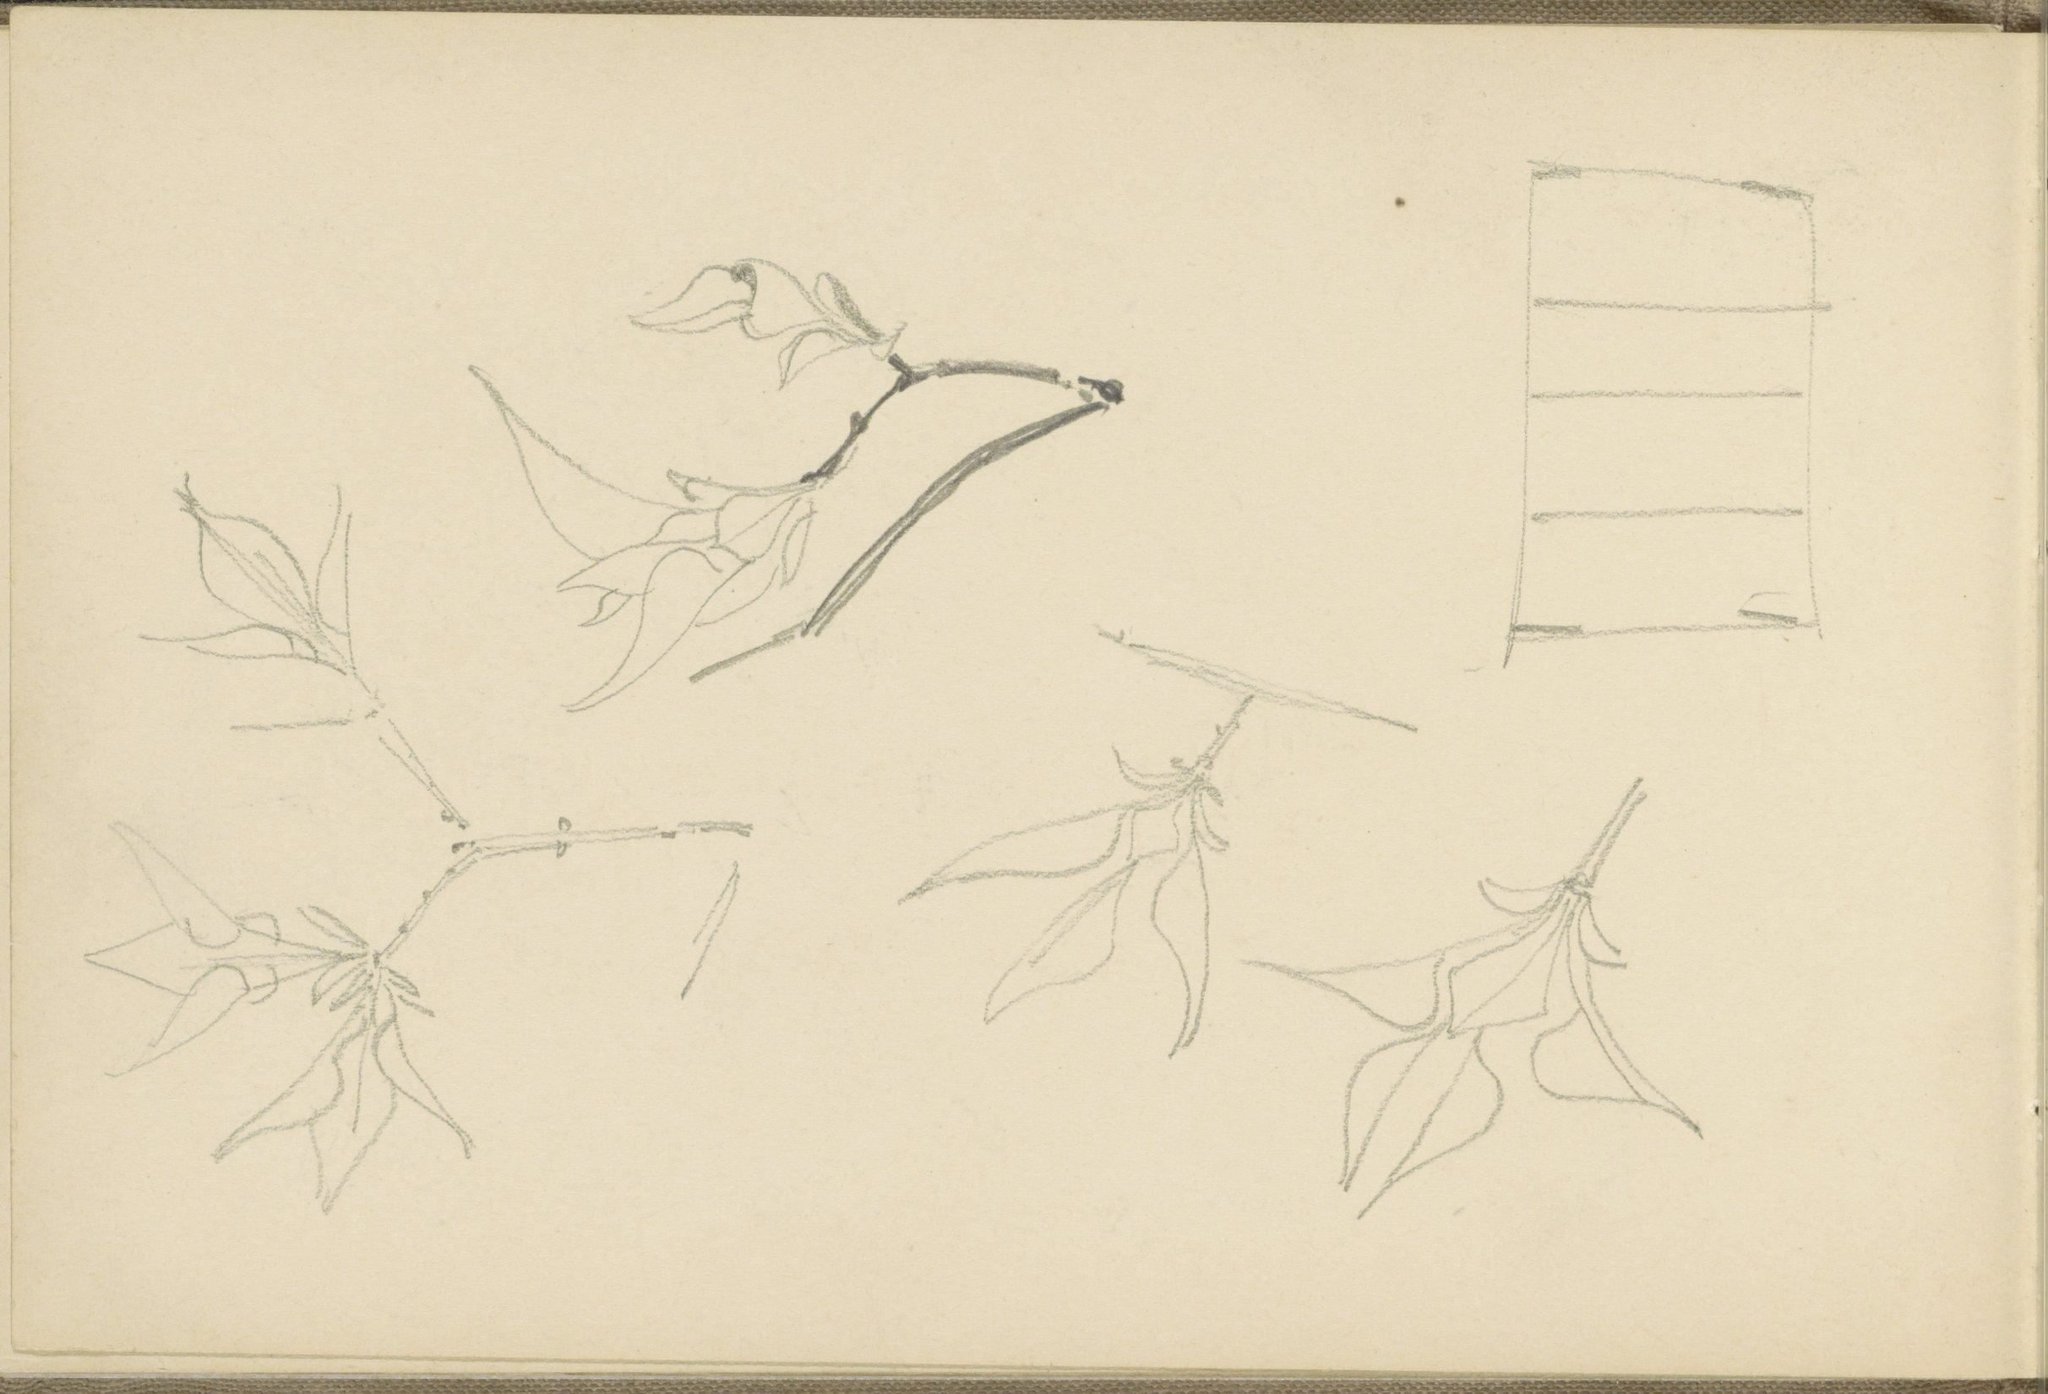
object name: sketchbook leaf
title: Takken met bloemen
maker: carel adolph lion cachet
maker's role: draughtsman, print maker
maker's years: 1864-1945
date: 1905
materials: paper, pencil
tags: flowers, plants; vegetation (+ branch, stick)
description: Blad 15 verso uit een schetsboek met 27 bladen.